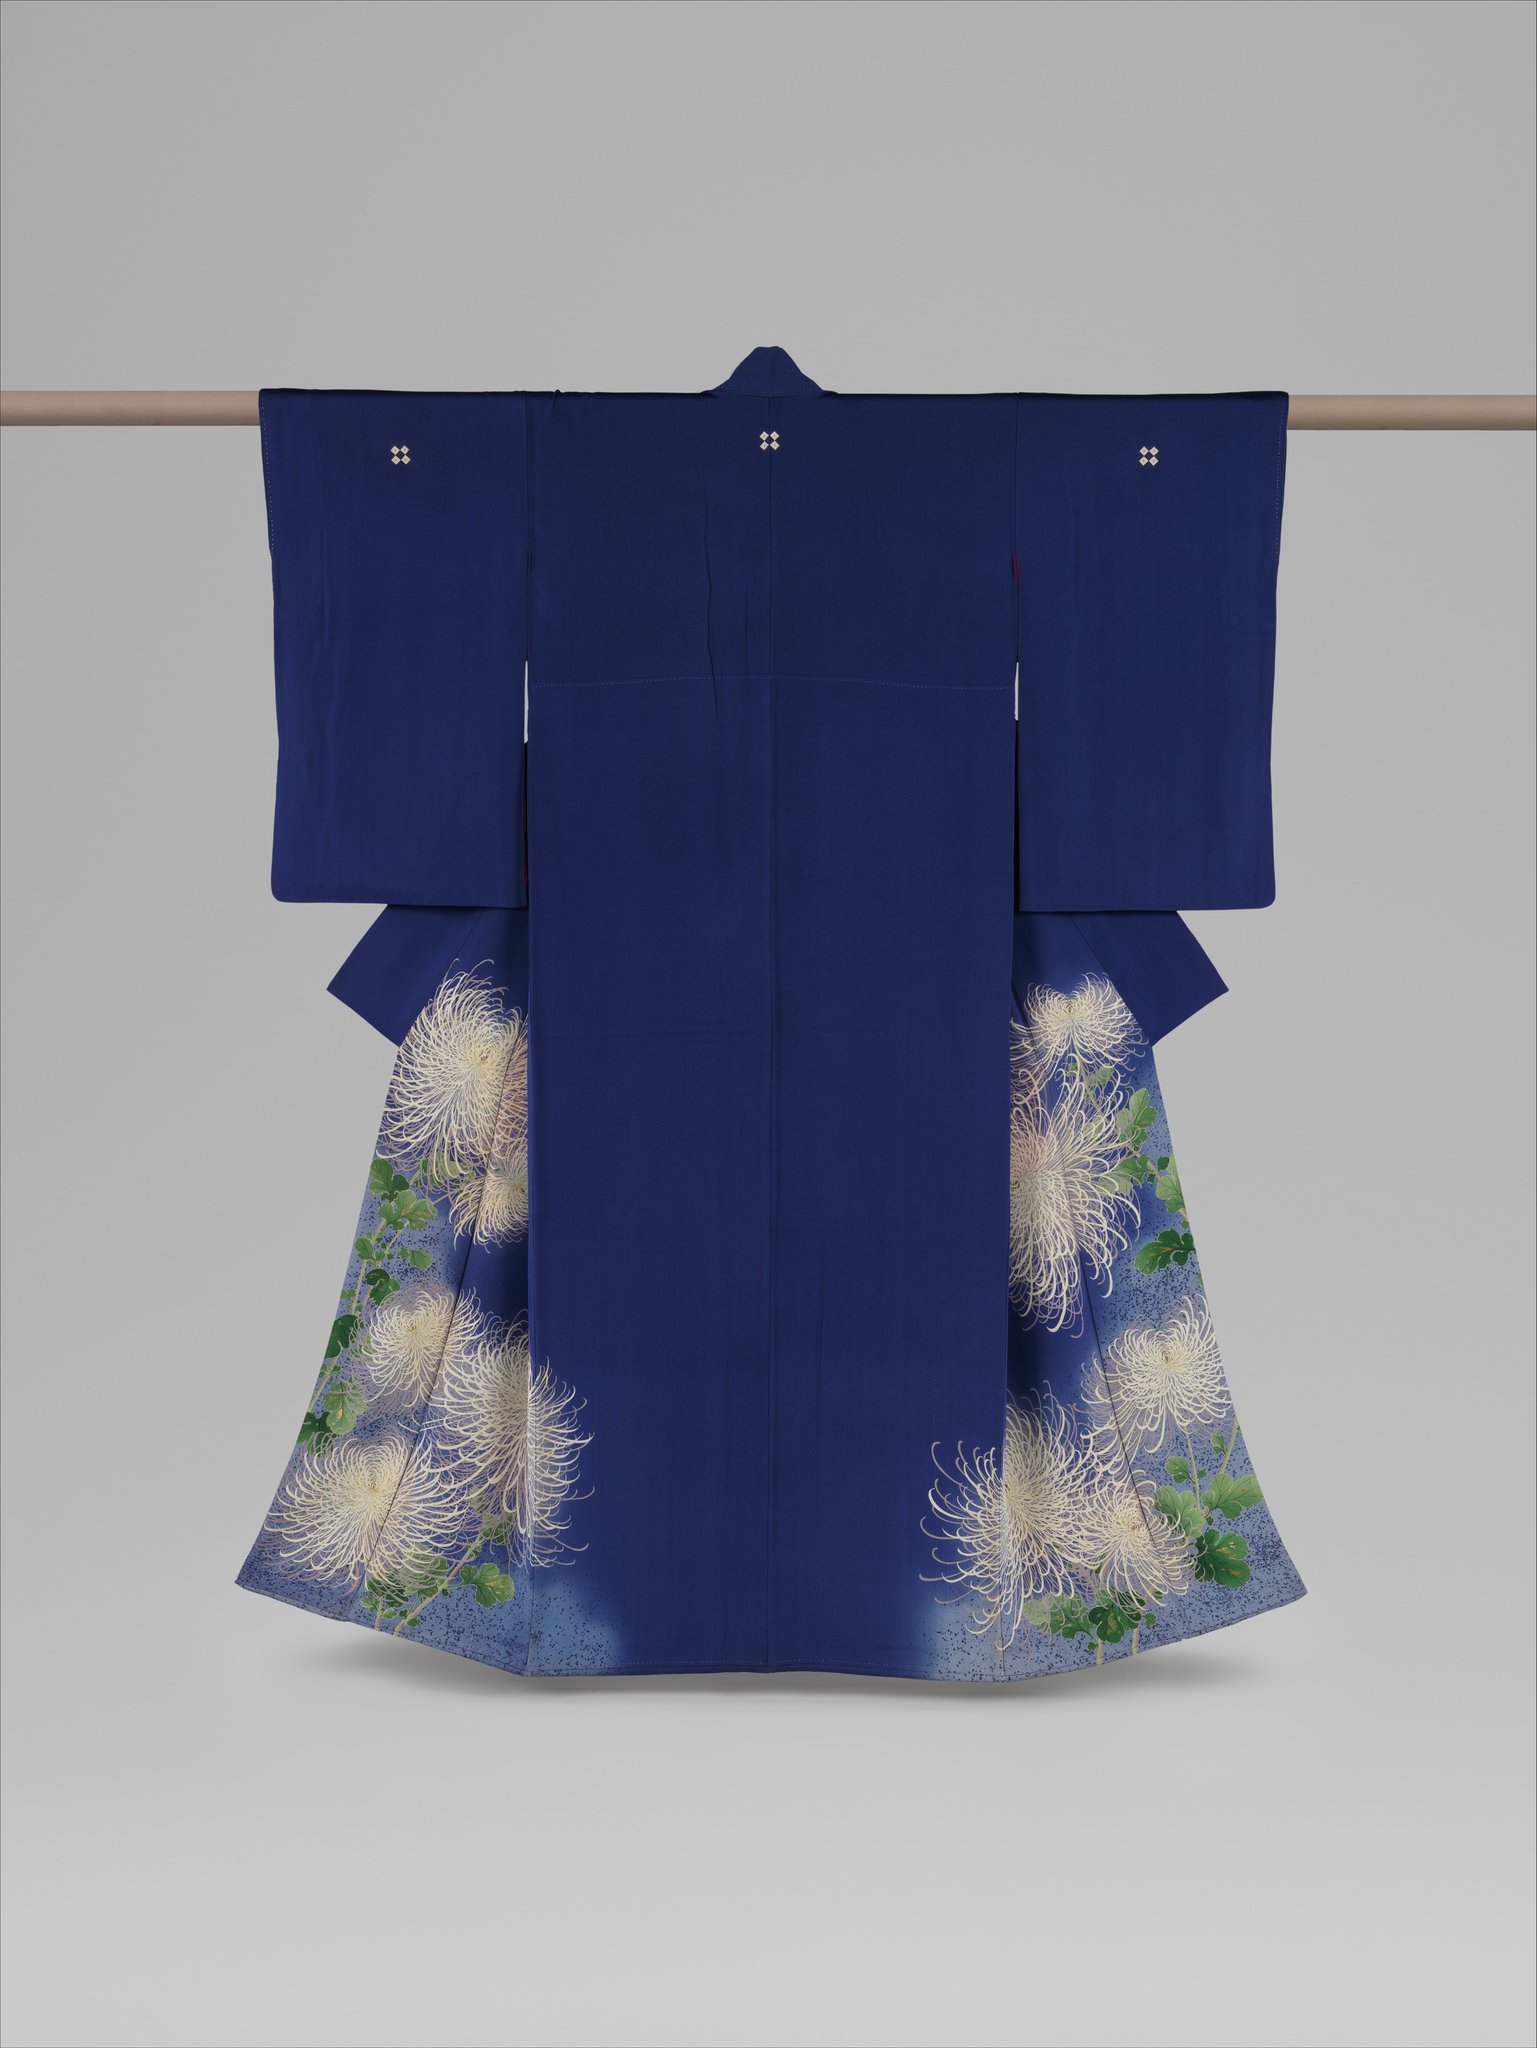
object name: kimono ensemble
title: Kimono Ensemble with Chrysanthemums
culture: japanese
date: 1912-1926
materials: metal thread, silk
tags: flowers